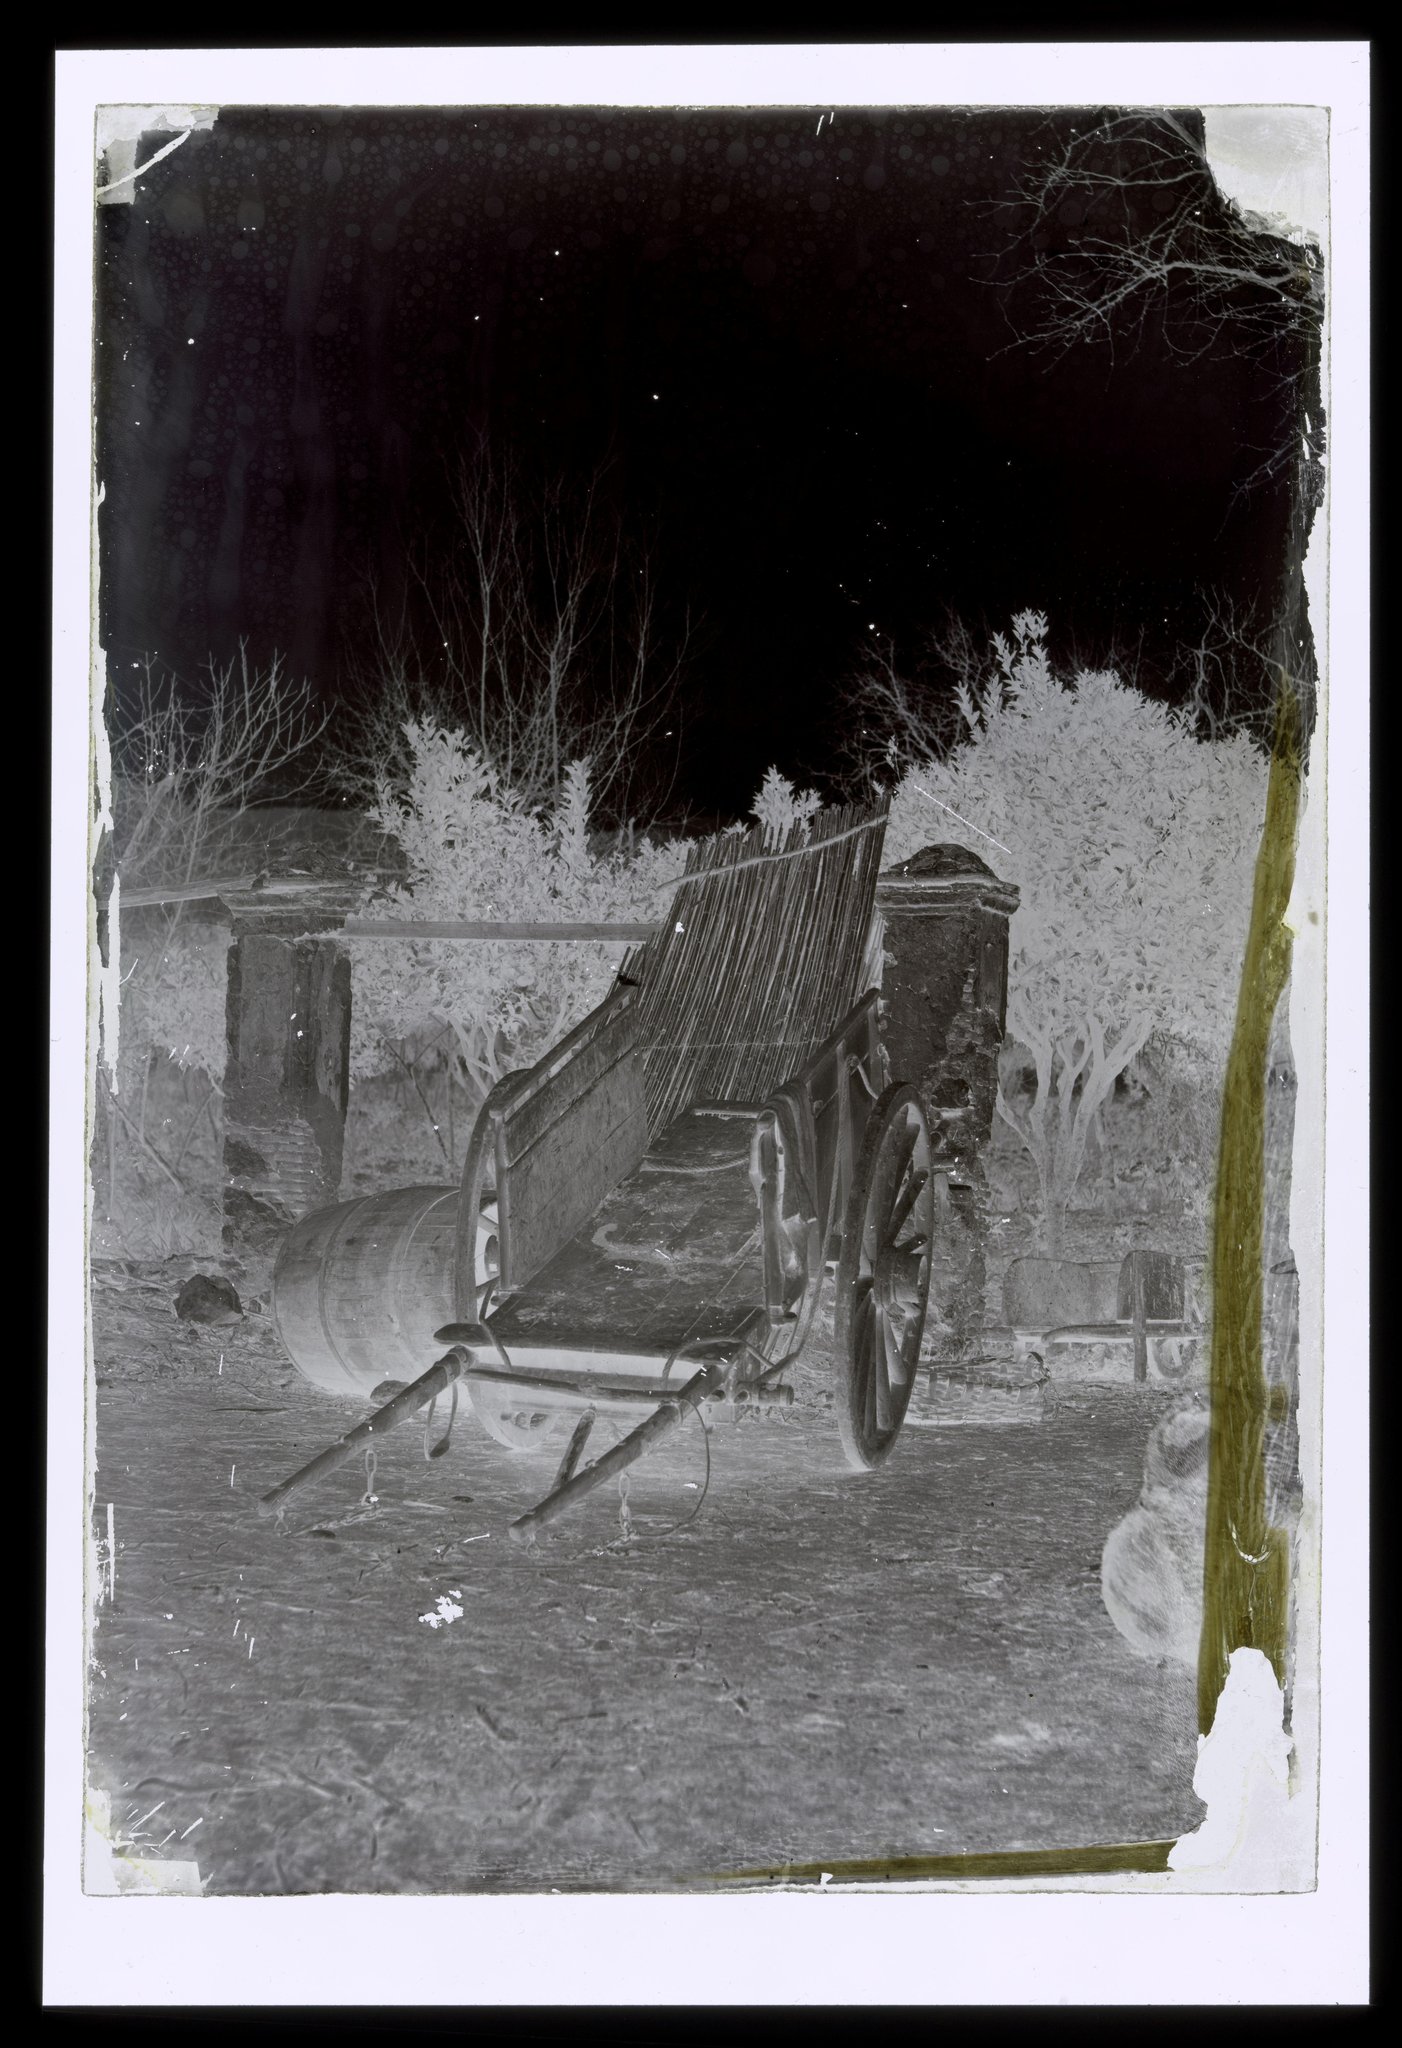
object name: glasnegatief, glasplaatnegatief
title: Houten kar in een tuin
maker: laurens lodewijk kleijn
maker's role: draughtsman, painter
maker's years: 1826-1909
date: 1850-1870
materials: glass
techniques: collodion process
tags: hand-cart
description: Onderdeel van een groep glasnegatieven uit de nalatenschap van de schilder Laurens Lodewijk Kleijn, met stillevens, portretten, zelfportretten en kunstreproducties.